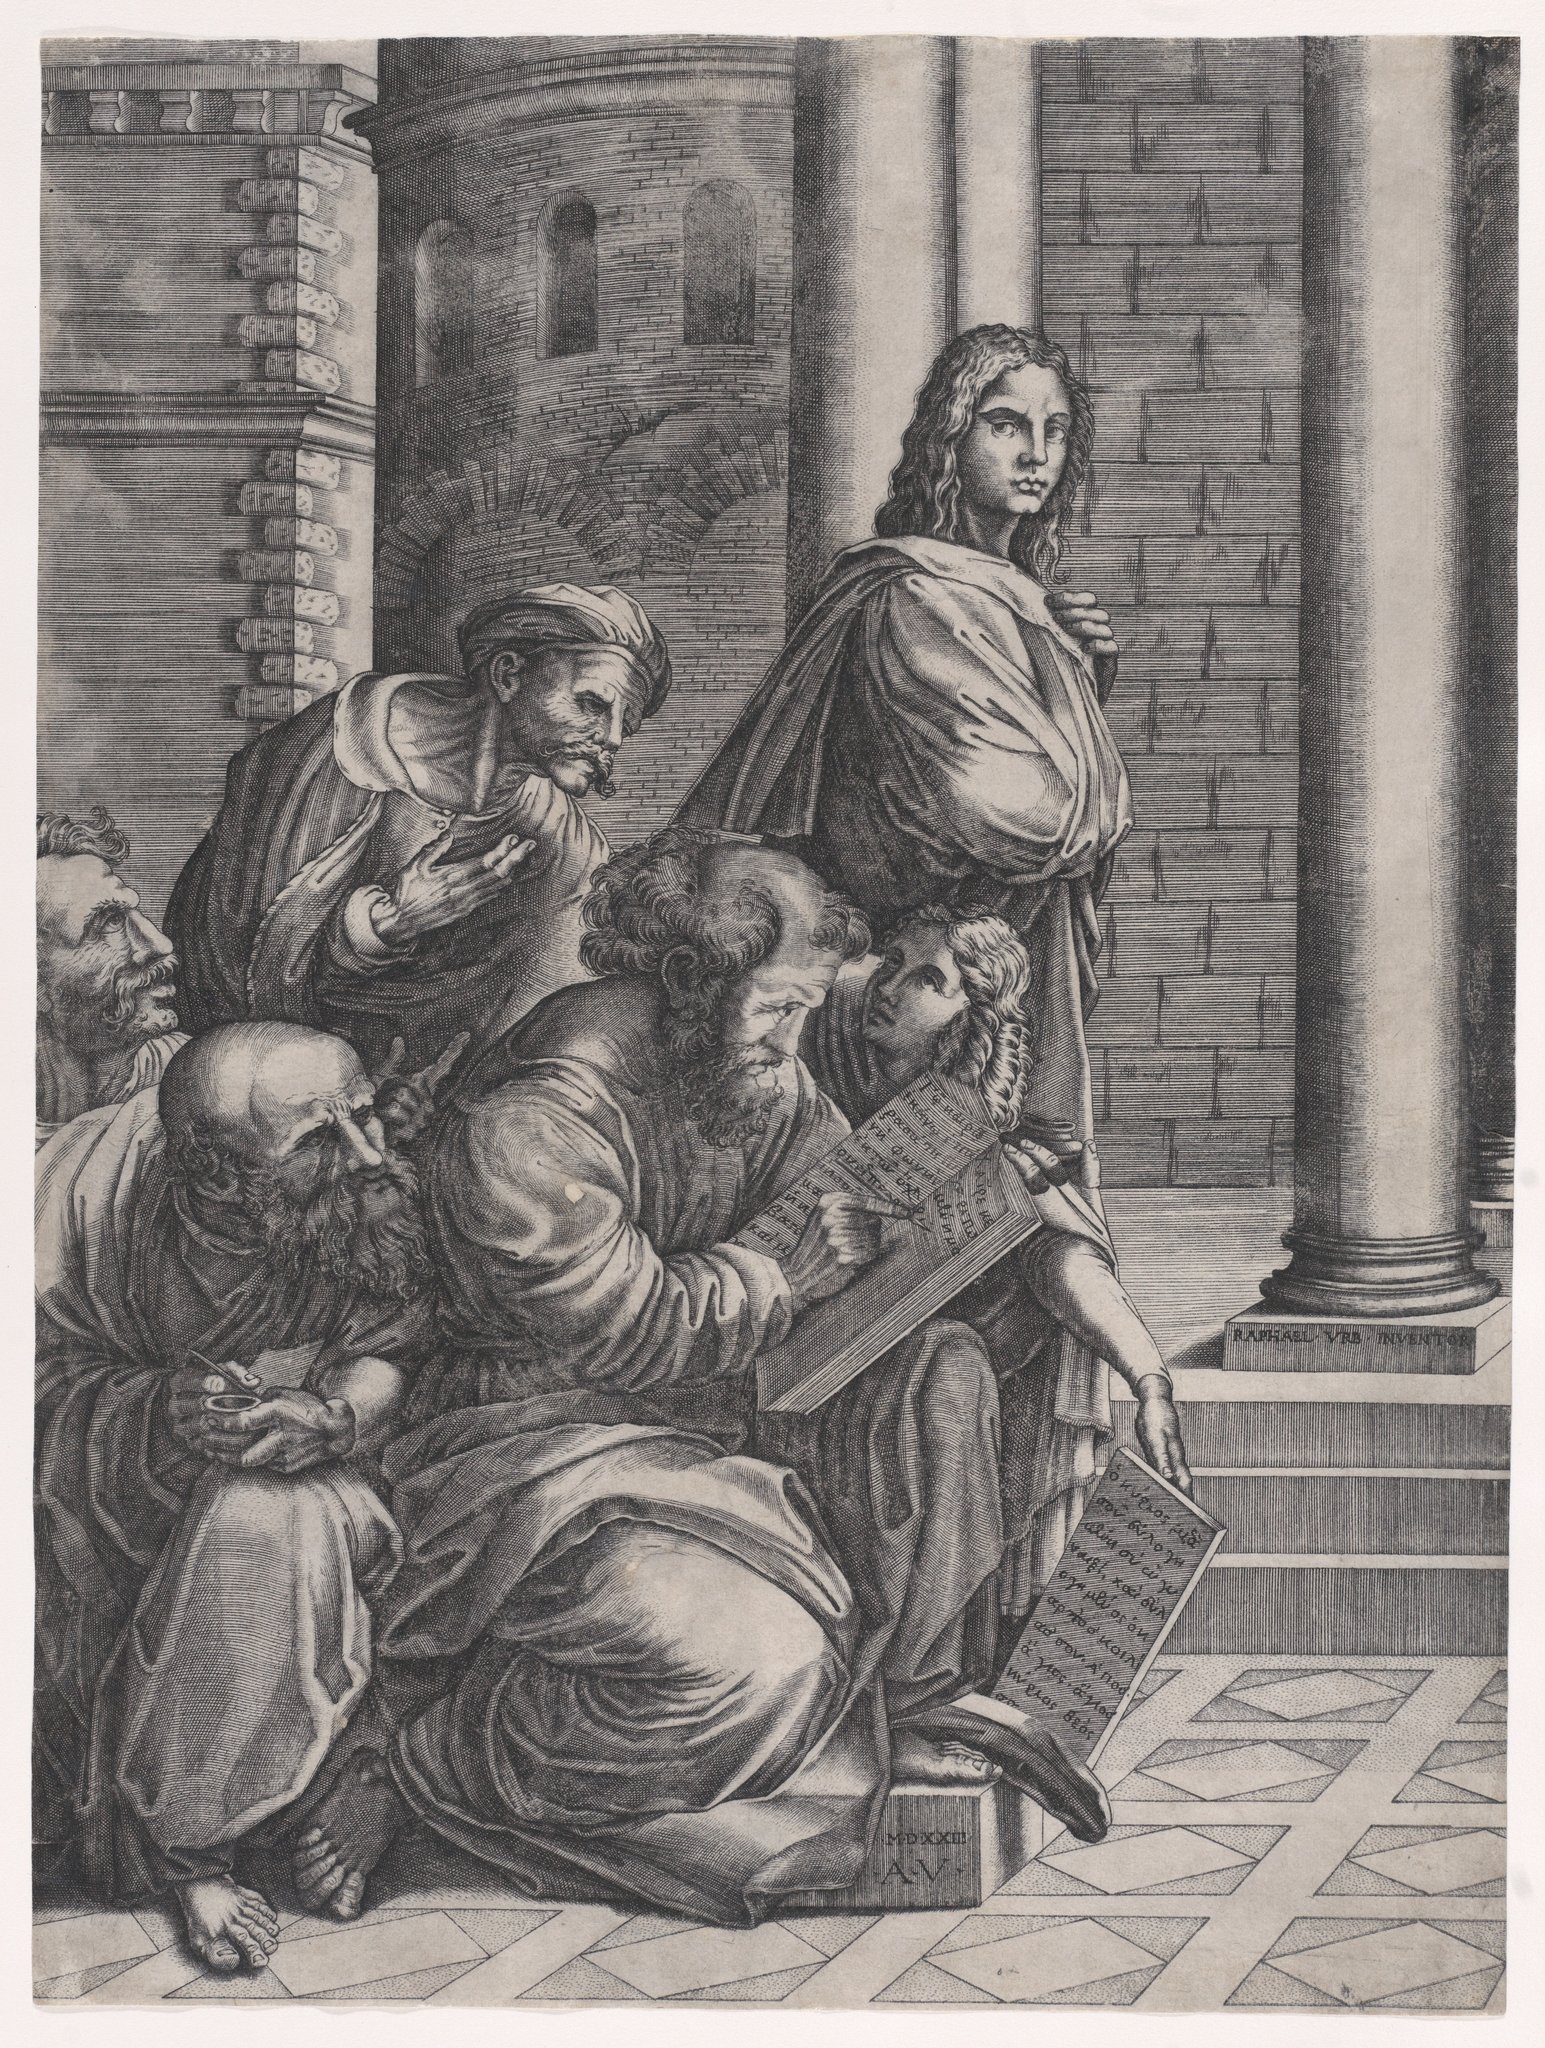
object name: print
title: The Group, from Raphael's "School of Athens"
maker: agostino veneziano (agostino dei musi)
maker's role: artist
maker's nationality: italian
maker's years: 1490-1536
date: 1523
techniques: engraving